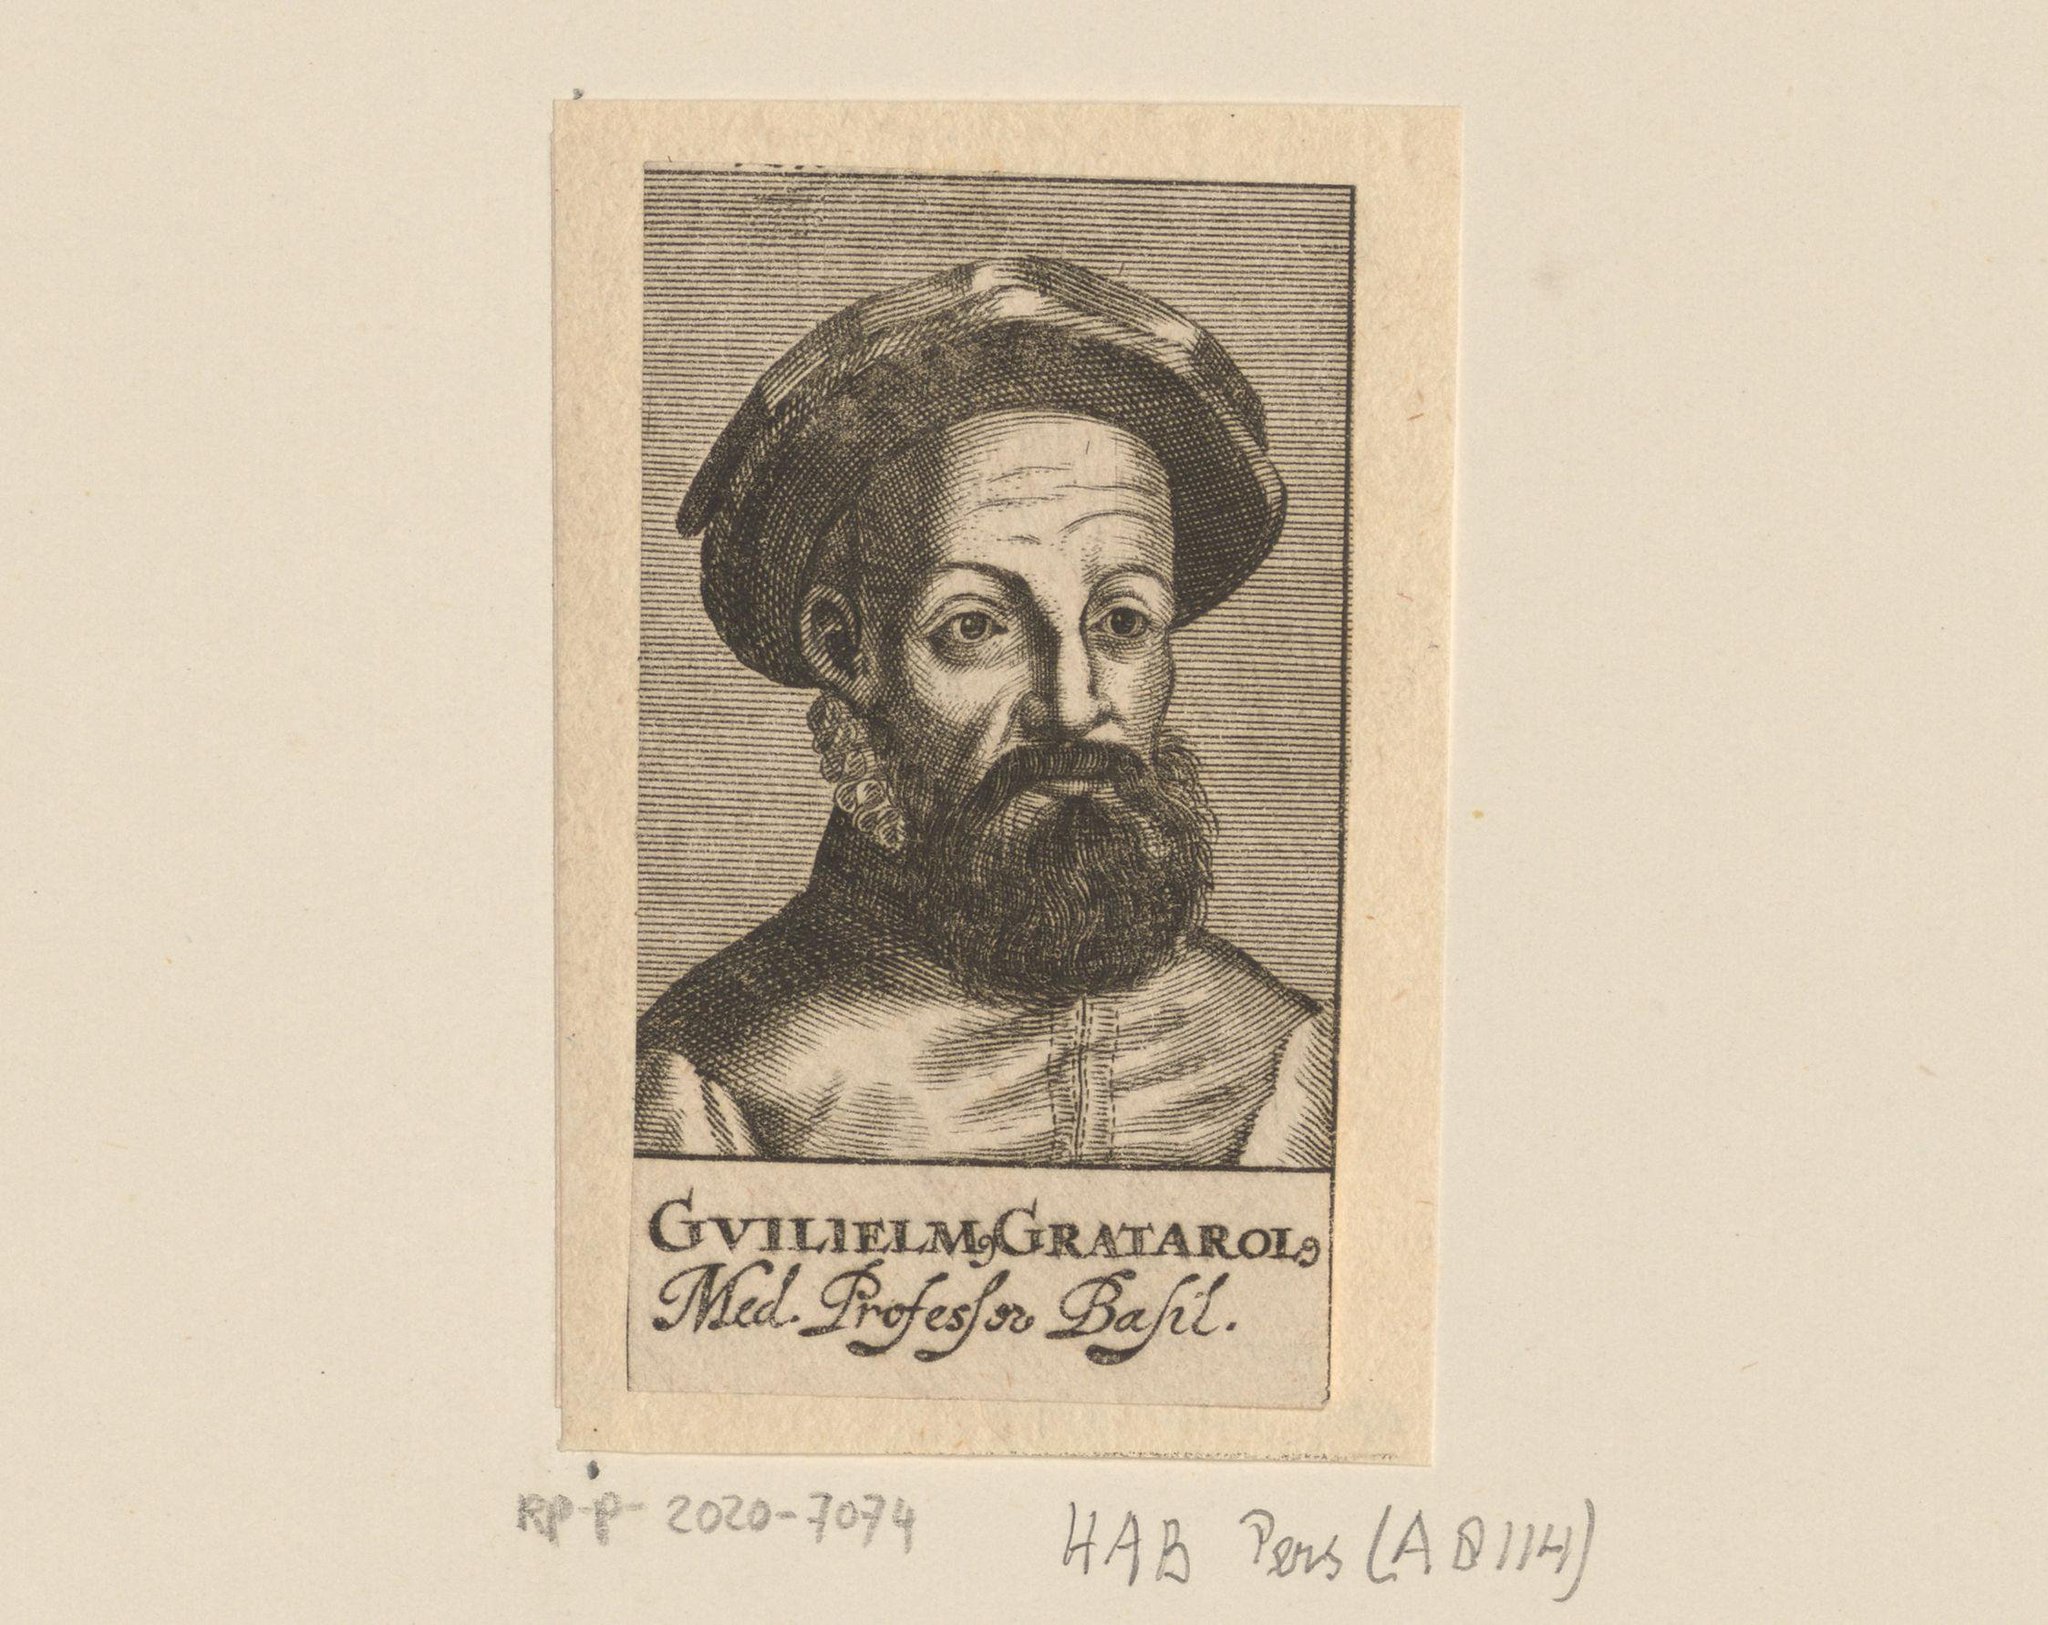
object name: print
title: Portret van een onbekende man, bekend als Giullielmus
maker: Anonymous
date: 1868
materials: paper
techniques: engraving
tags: historical persons, writer, poet, author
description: Prent waarschijnlijk uit: Freher, Paul. Theatrum virorum eruditione clarorum. Neurenberg: Johann Hoffmann, 1688.